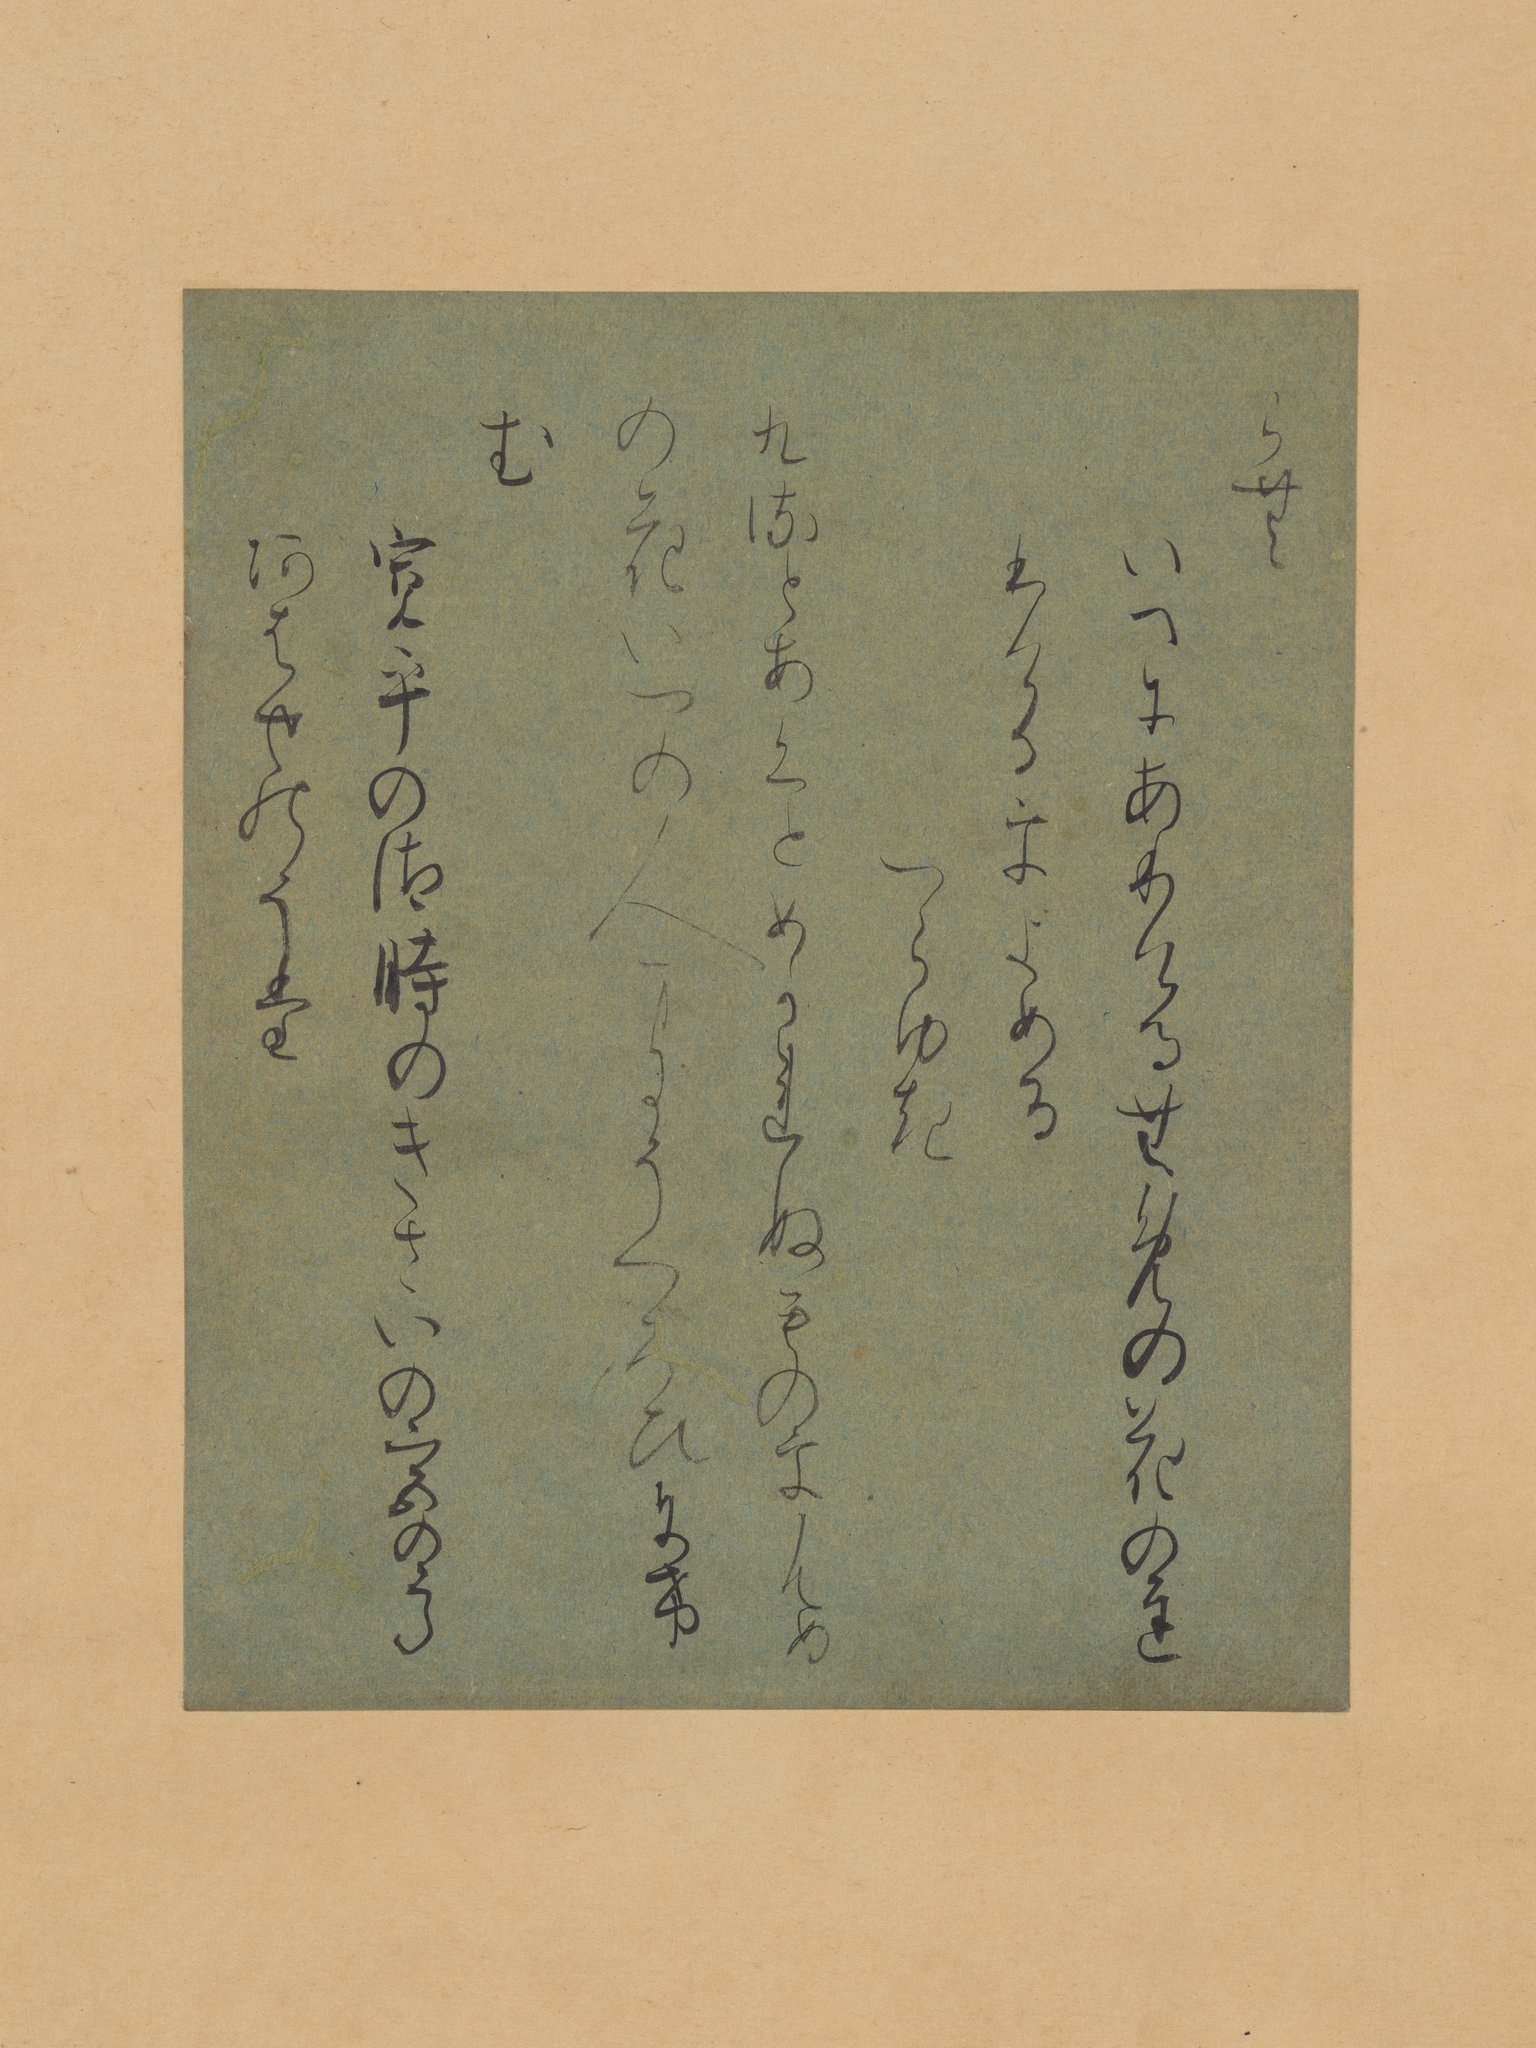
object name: hanging scroll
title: Poems about Plum Blossoms, from the “Sekido-bon Version of Collection of Poems Ancient and Modern”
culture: japanese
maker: fujiwara no yukinari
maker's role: artist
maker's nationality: japanese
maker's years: 972-1027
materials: ink, paper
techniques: bookbinding, dyeing